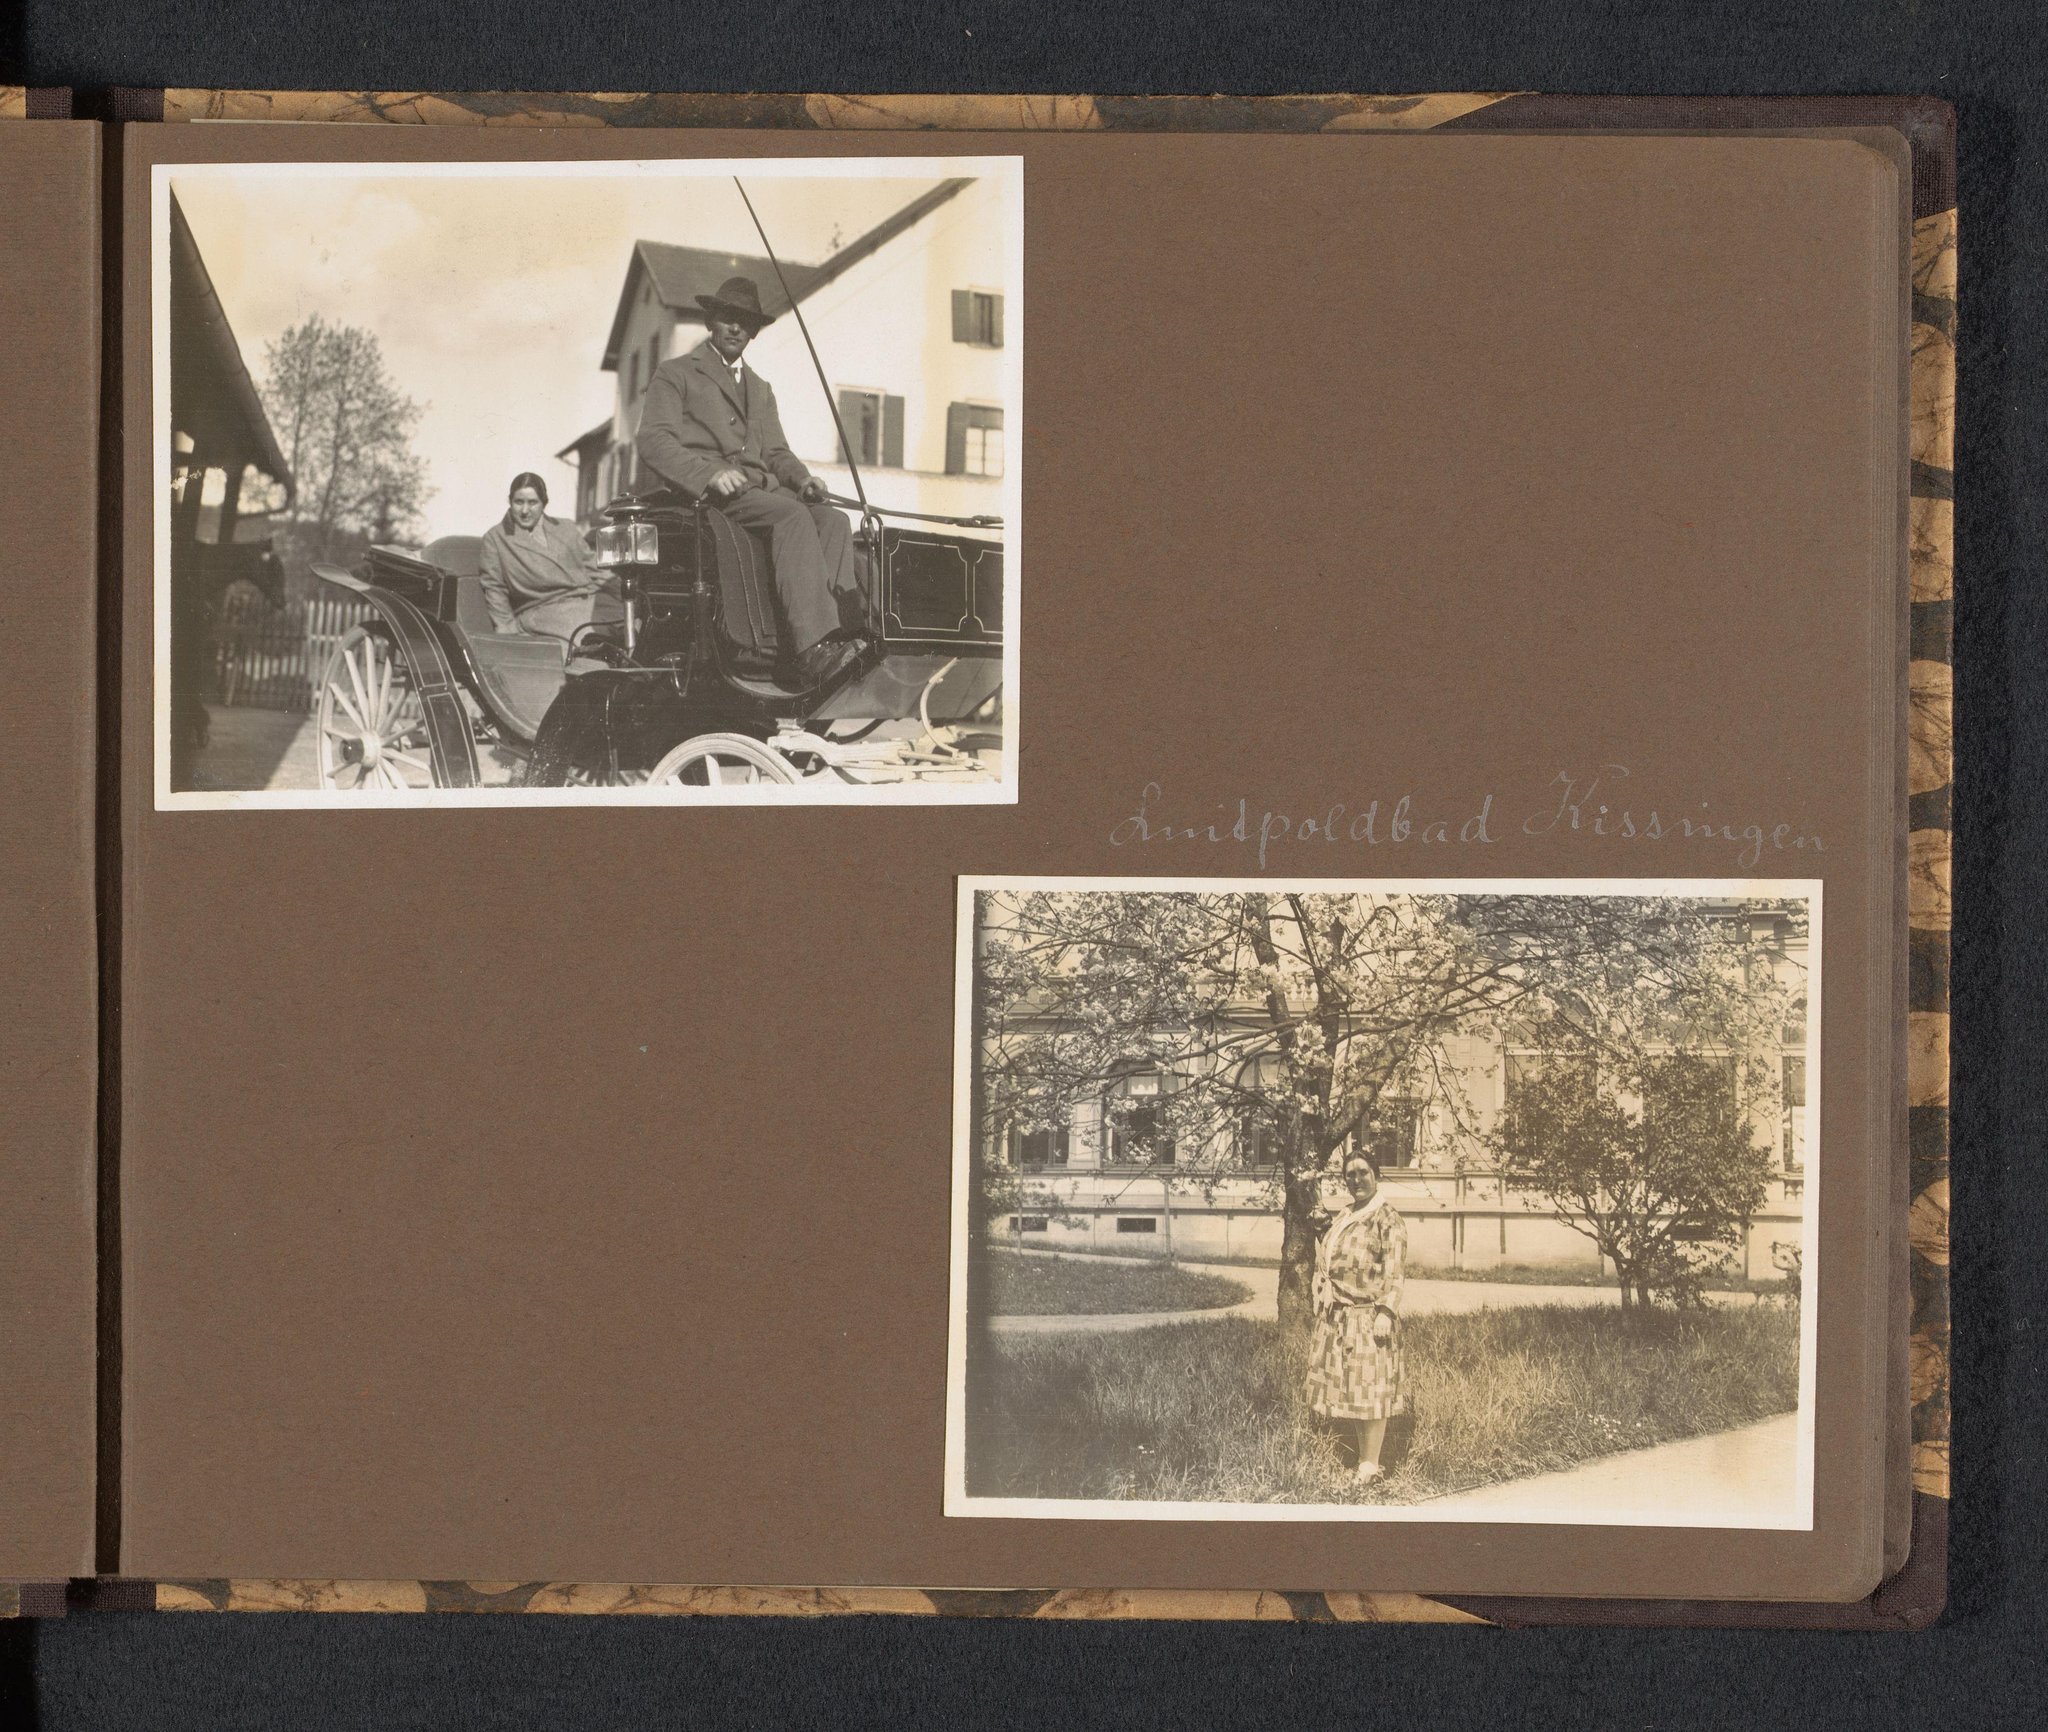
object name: photograph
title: Else Wachenheimer-Moos voor het badhuis van Luitpoldbad, april-mei 1927, Bad Kissingen (Beieren)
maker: else wachenheimer-moos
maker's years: 1895-1944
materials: paper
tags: else wachenheimer-moos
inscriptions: inscription: ‘Luitpoldbad Kissingen’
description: Albumblad bevat twee foto's van Else Wachenheimer-Moos. Afkomstig uit album half formaat, kartonomslag met koordbinding en lichte veelvormige vormen op voorzijde.